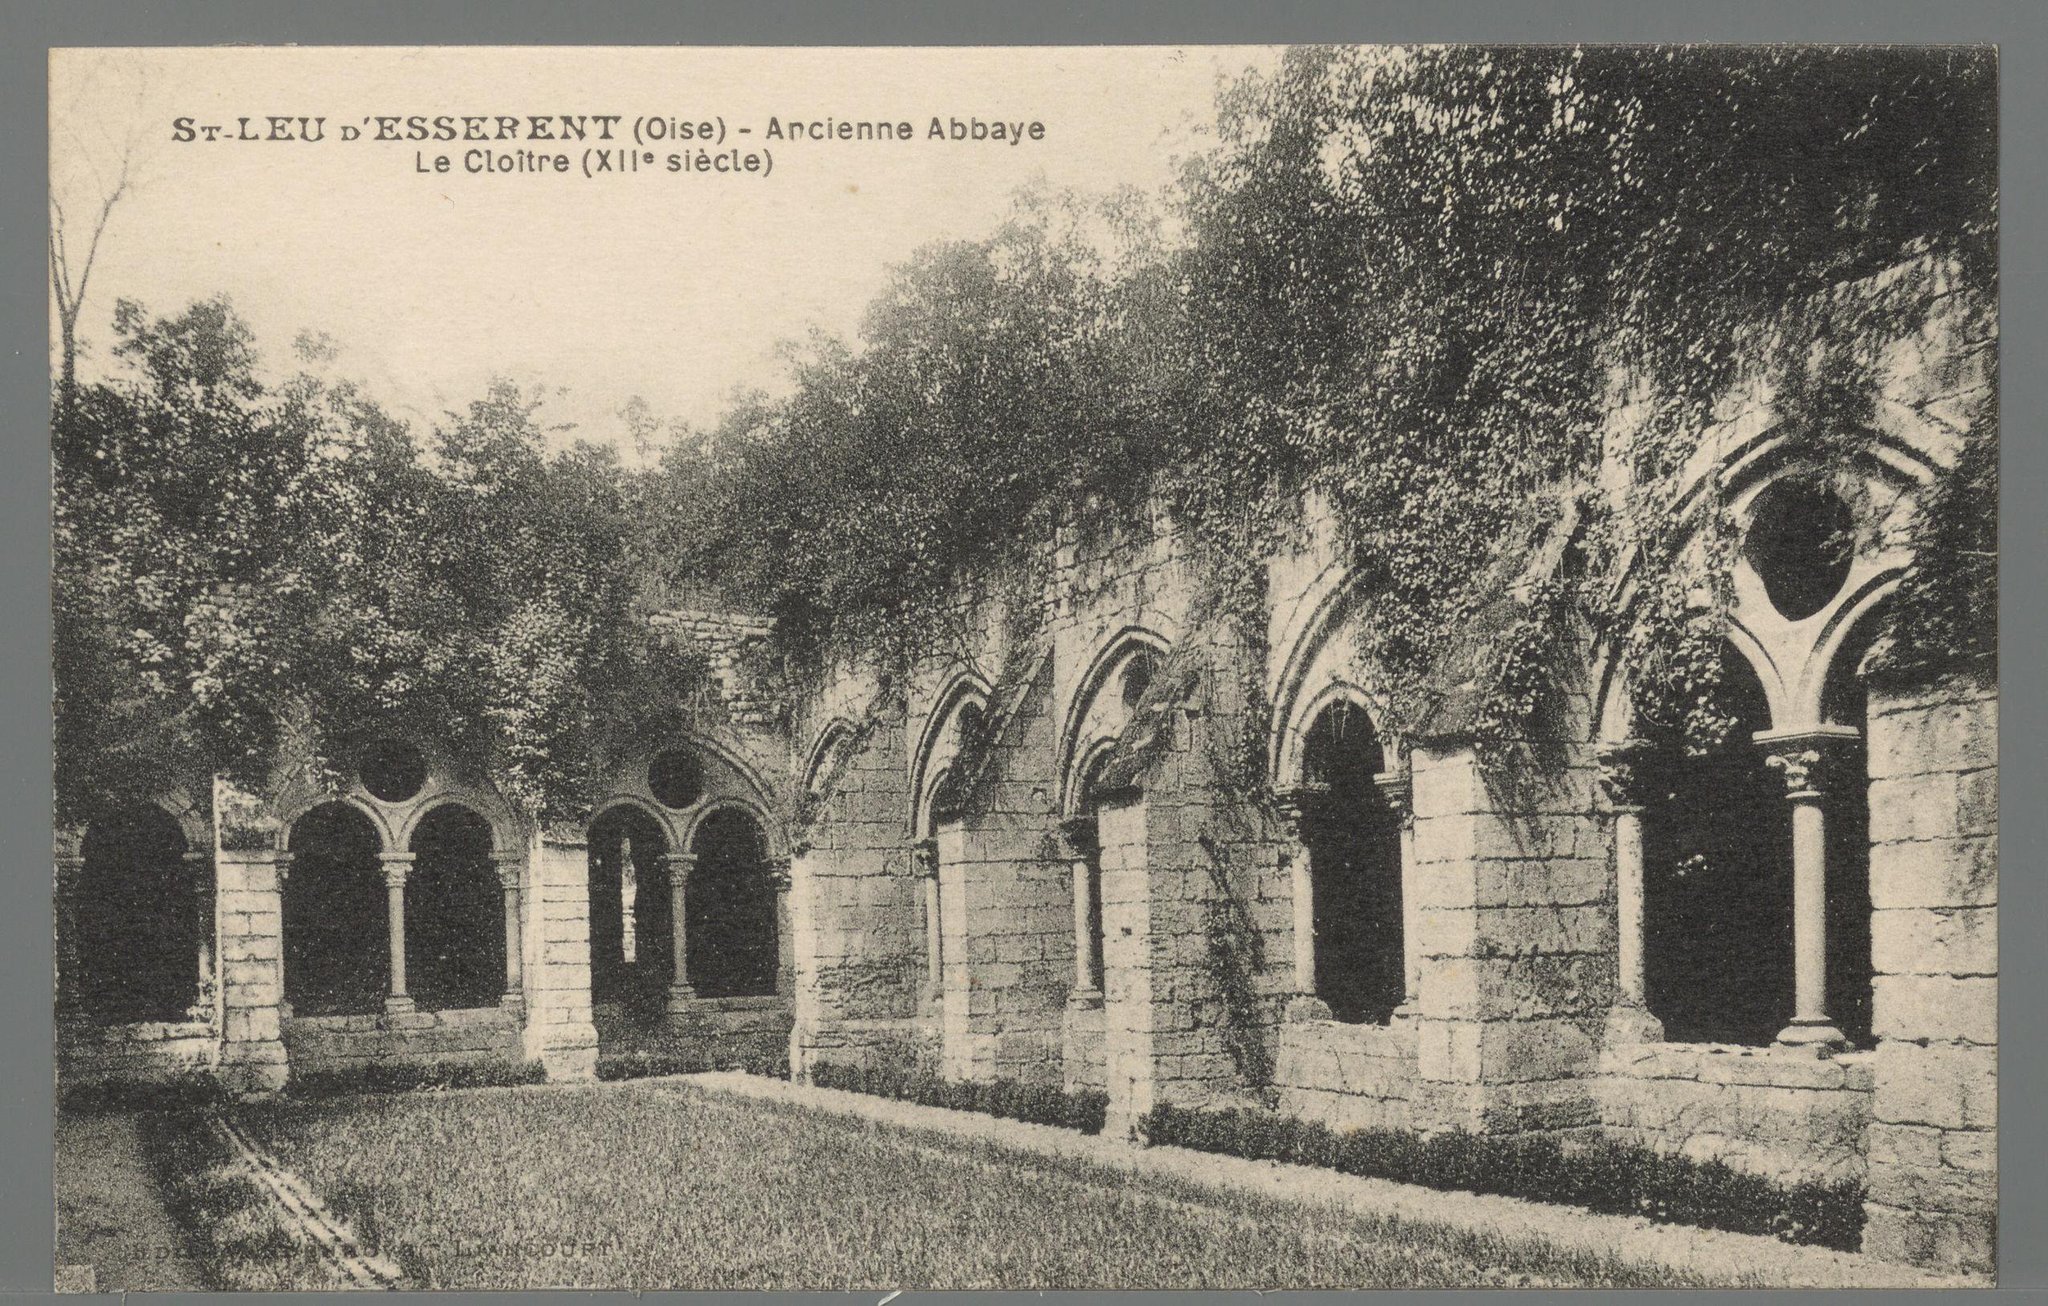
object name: ansichtkaart, prentbriefkaart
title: St-Leu d'Esserent (Oise) - Ancienne Abbaye. Le Cloître (XIIe siècle)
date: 1903-1930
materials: cardboard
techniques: photograph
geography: saint-leu-d'esserent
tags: abbey, monastery, convent ~ roman catholic church